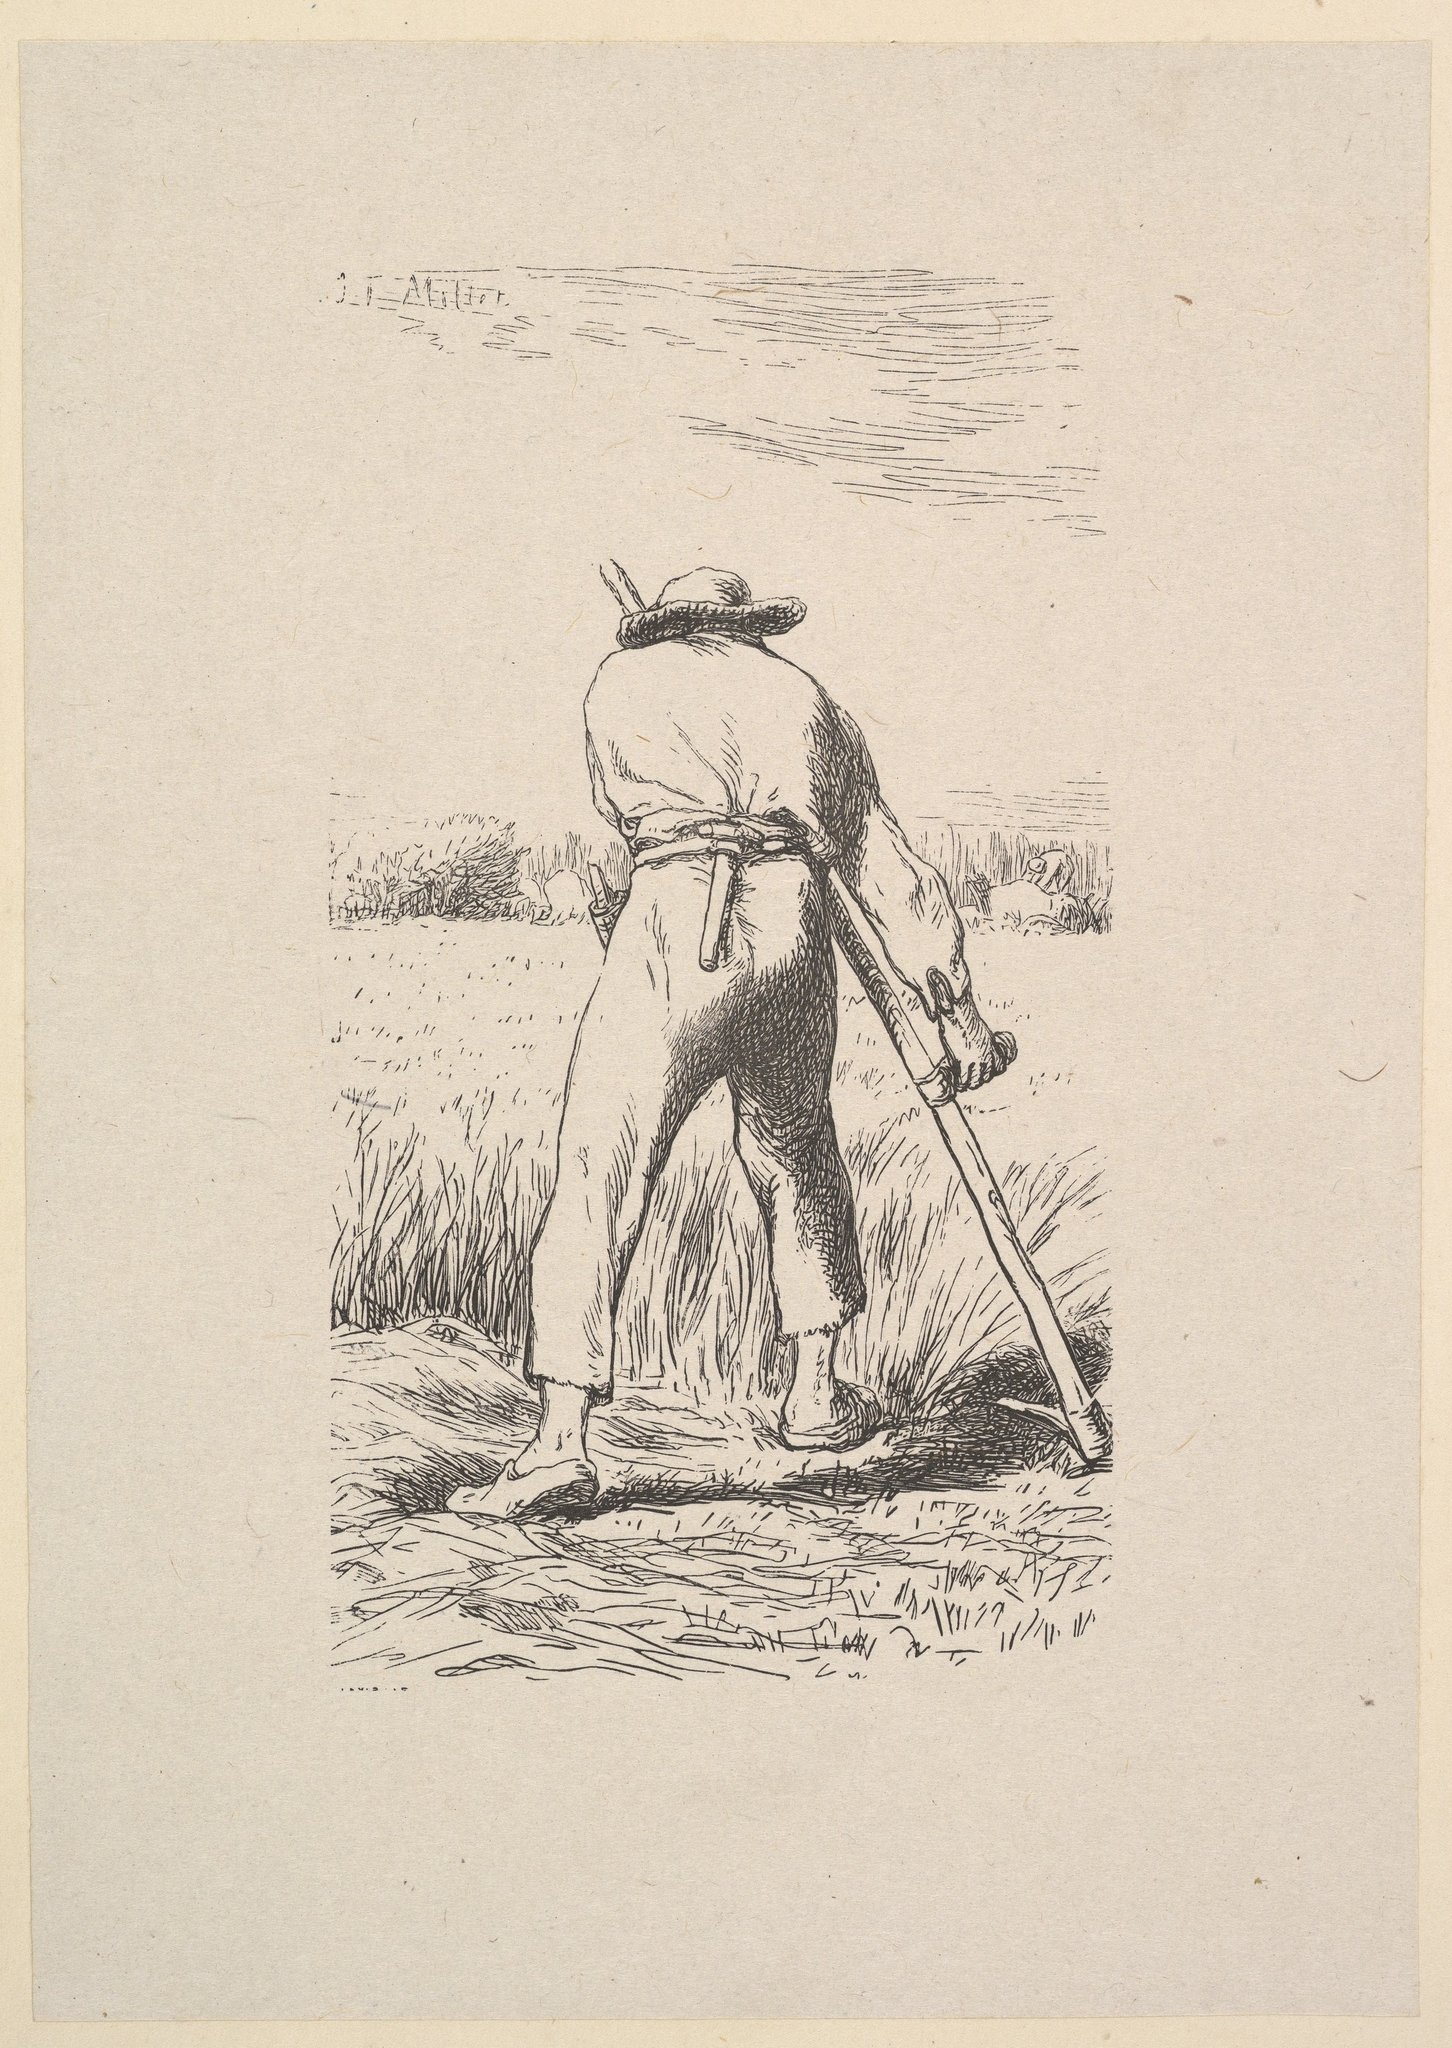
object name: print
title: The Wheat Reaper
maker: jean-françois millet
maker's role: artist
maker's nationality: french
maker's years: 1814-1875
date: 1853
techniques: printmaking, woodcut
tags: men,working